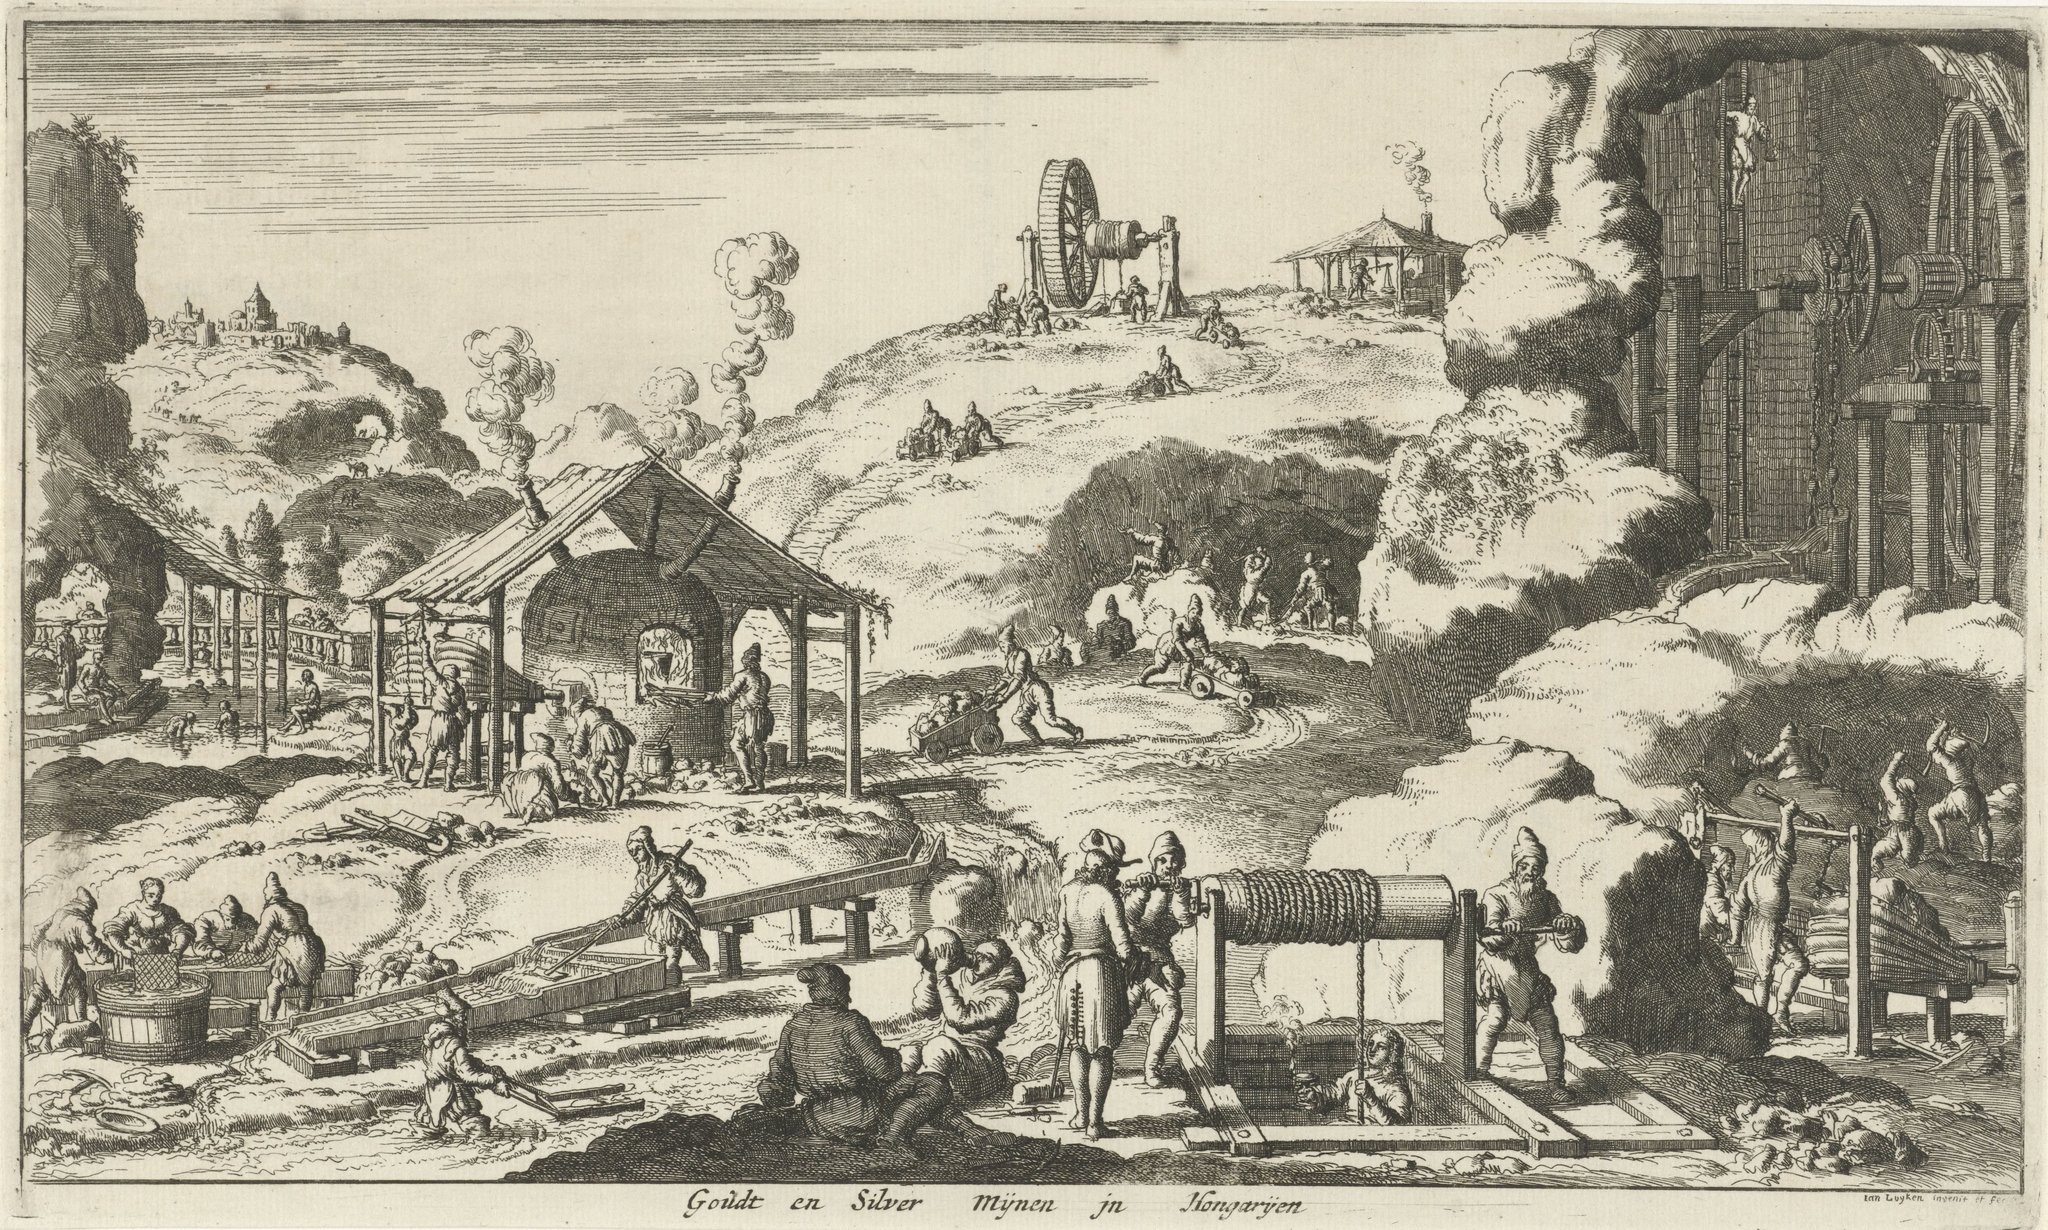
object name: print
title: Goudt en Silver Mijnen in Hongarijen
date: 1682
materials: paper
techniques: etching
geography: amsterdam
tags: opencast mine; strip mining, minerals and metals: silver, minerals and metals: gold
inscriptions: collector's mark: Lugt 2228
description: Illustratie opgenomen in: Brown, Edward. Naauwkeurige en gedenkwaardige reysen van Edward Brown (...) door Nederland, Duytsland, Hongaryen, Boek II, p. 111. Amsterdam: Jan Claesz ten Hoorn, 1682.